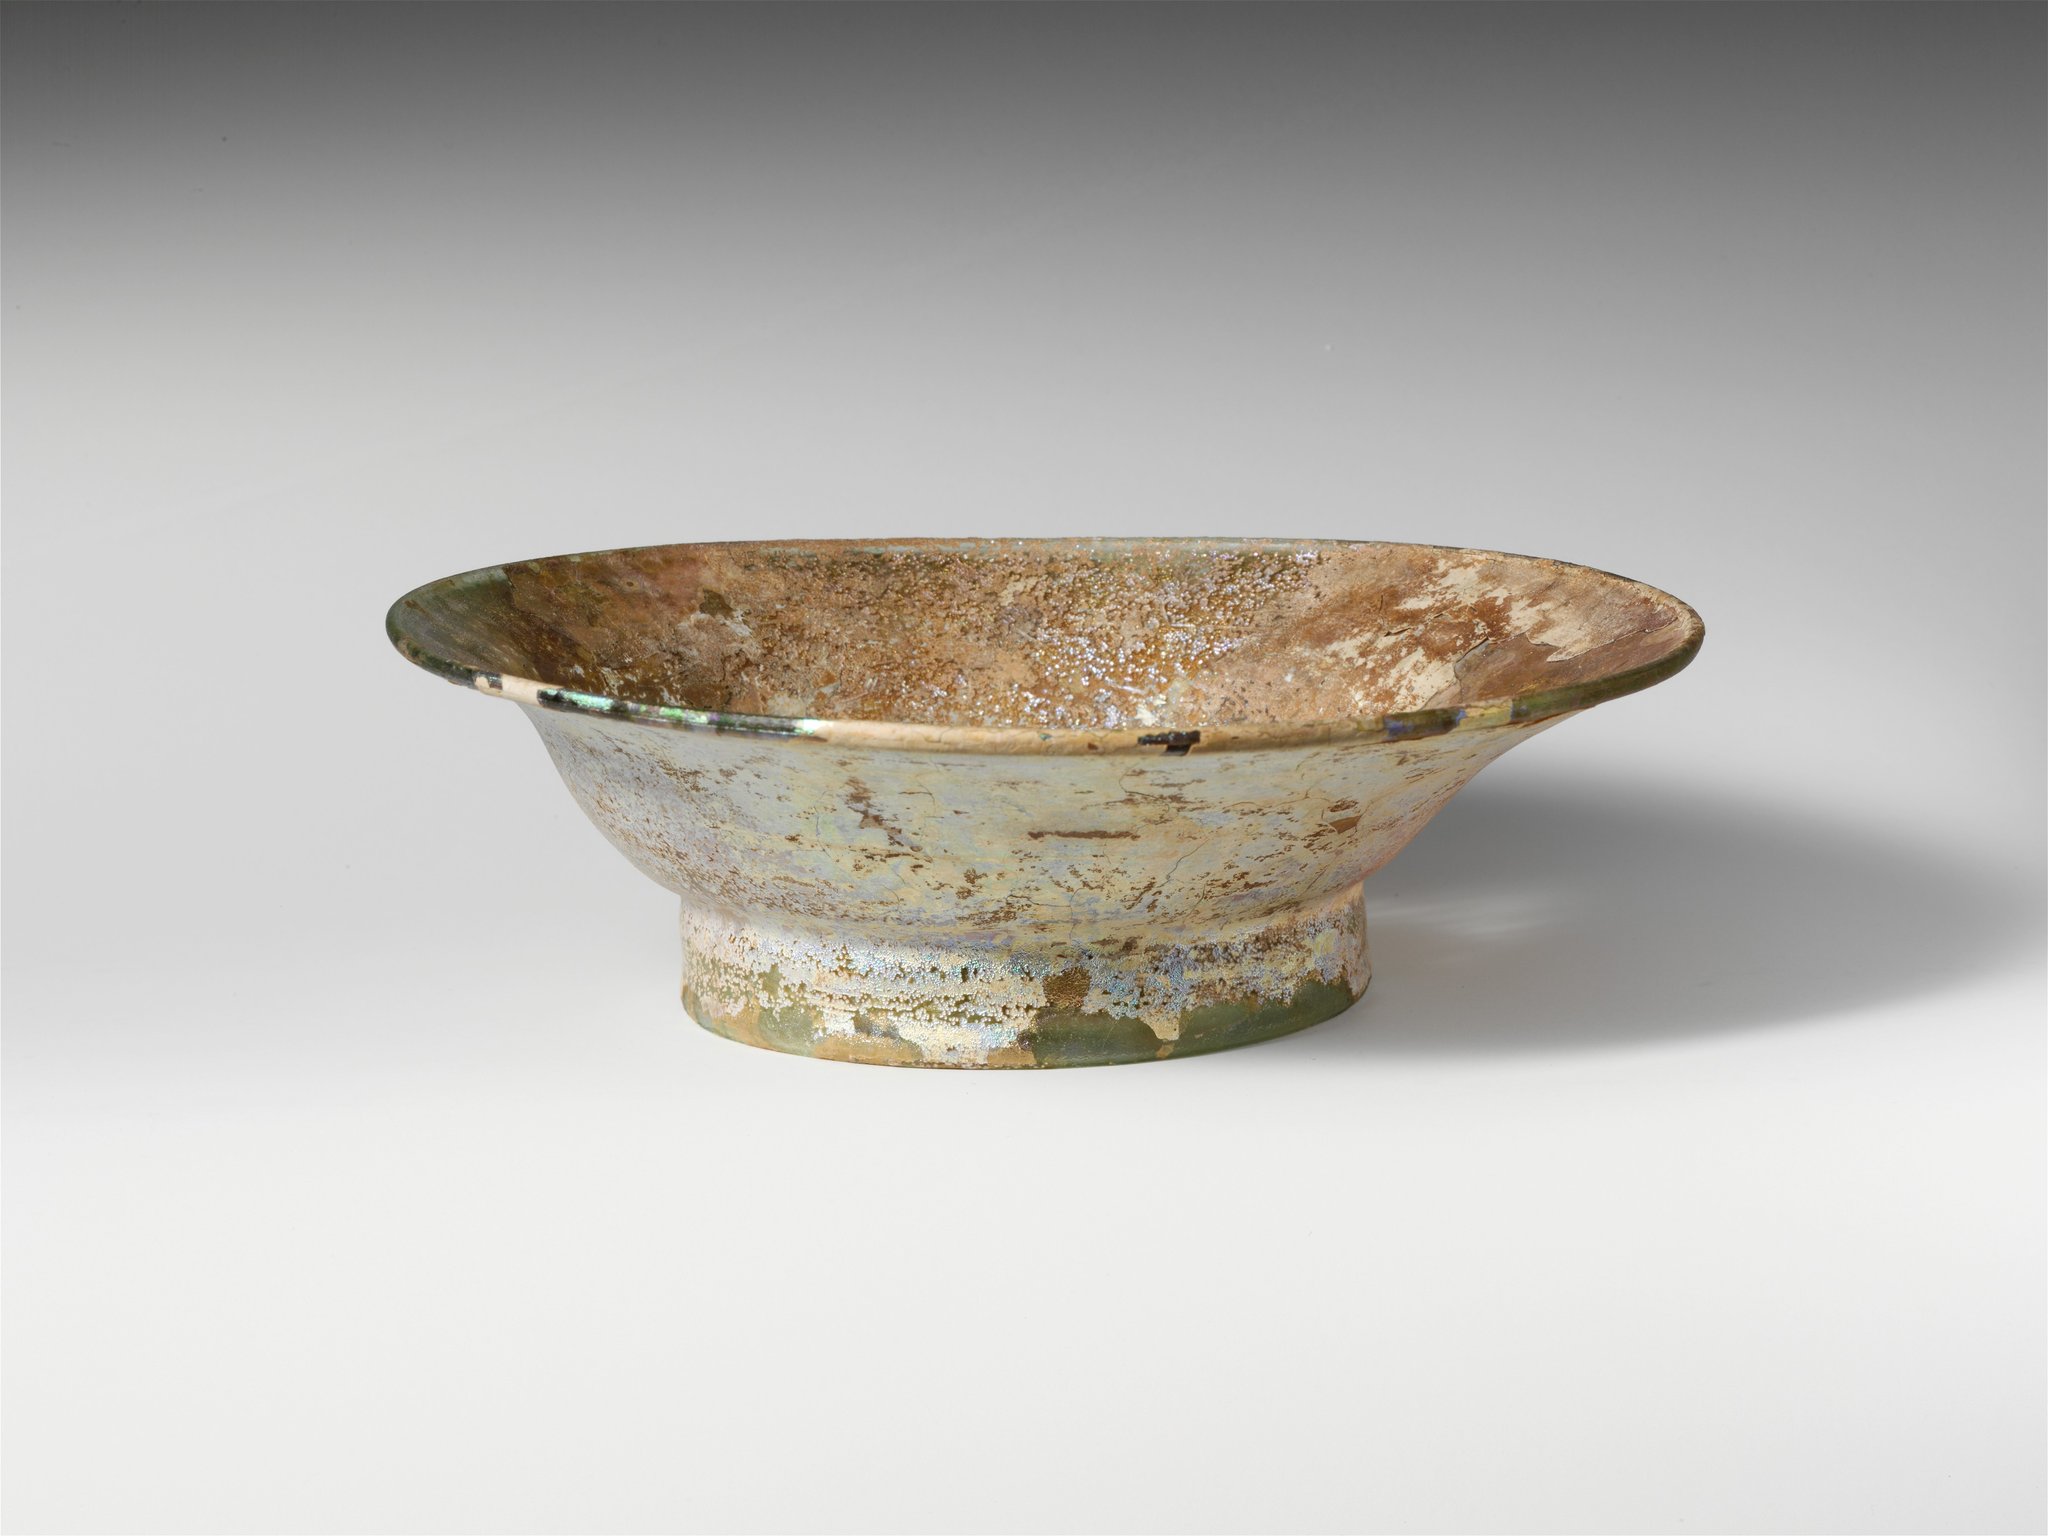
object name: dish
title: Glass dish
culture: roman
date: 301-400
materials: glass